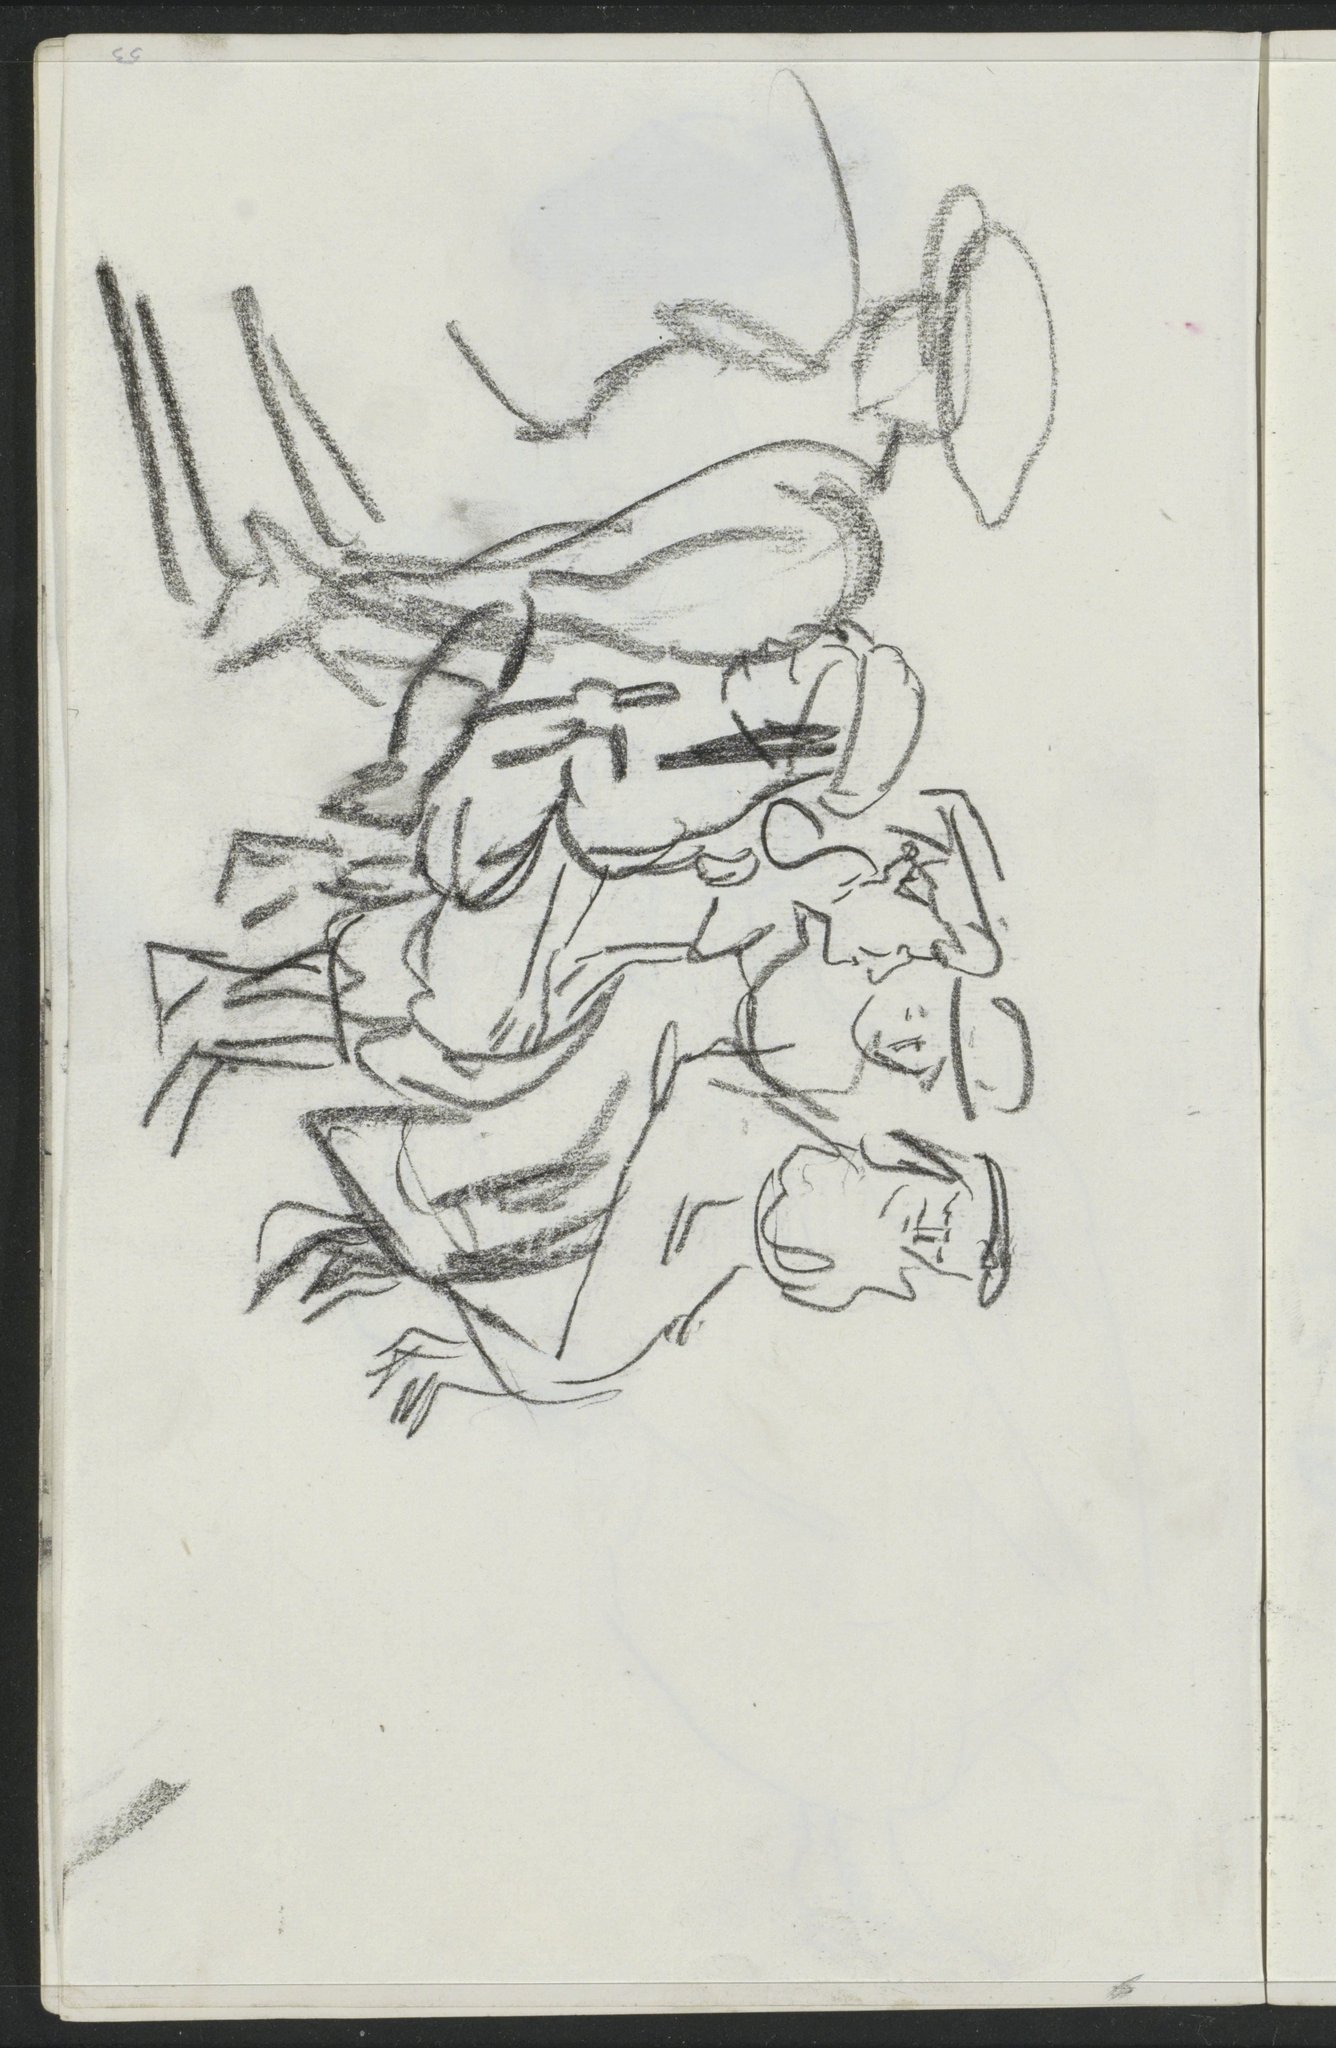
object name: sketchbook leaf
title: Groep zittende vrouwen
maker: isaac israels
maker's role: draughtsman, painter, print maker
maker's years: 1865-1934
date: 1875-1934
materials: chalk, paper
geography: amsterdam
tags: adult woman (+ sitting)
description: Blad 8 verso uit schetsboek XI met 30 bladen.